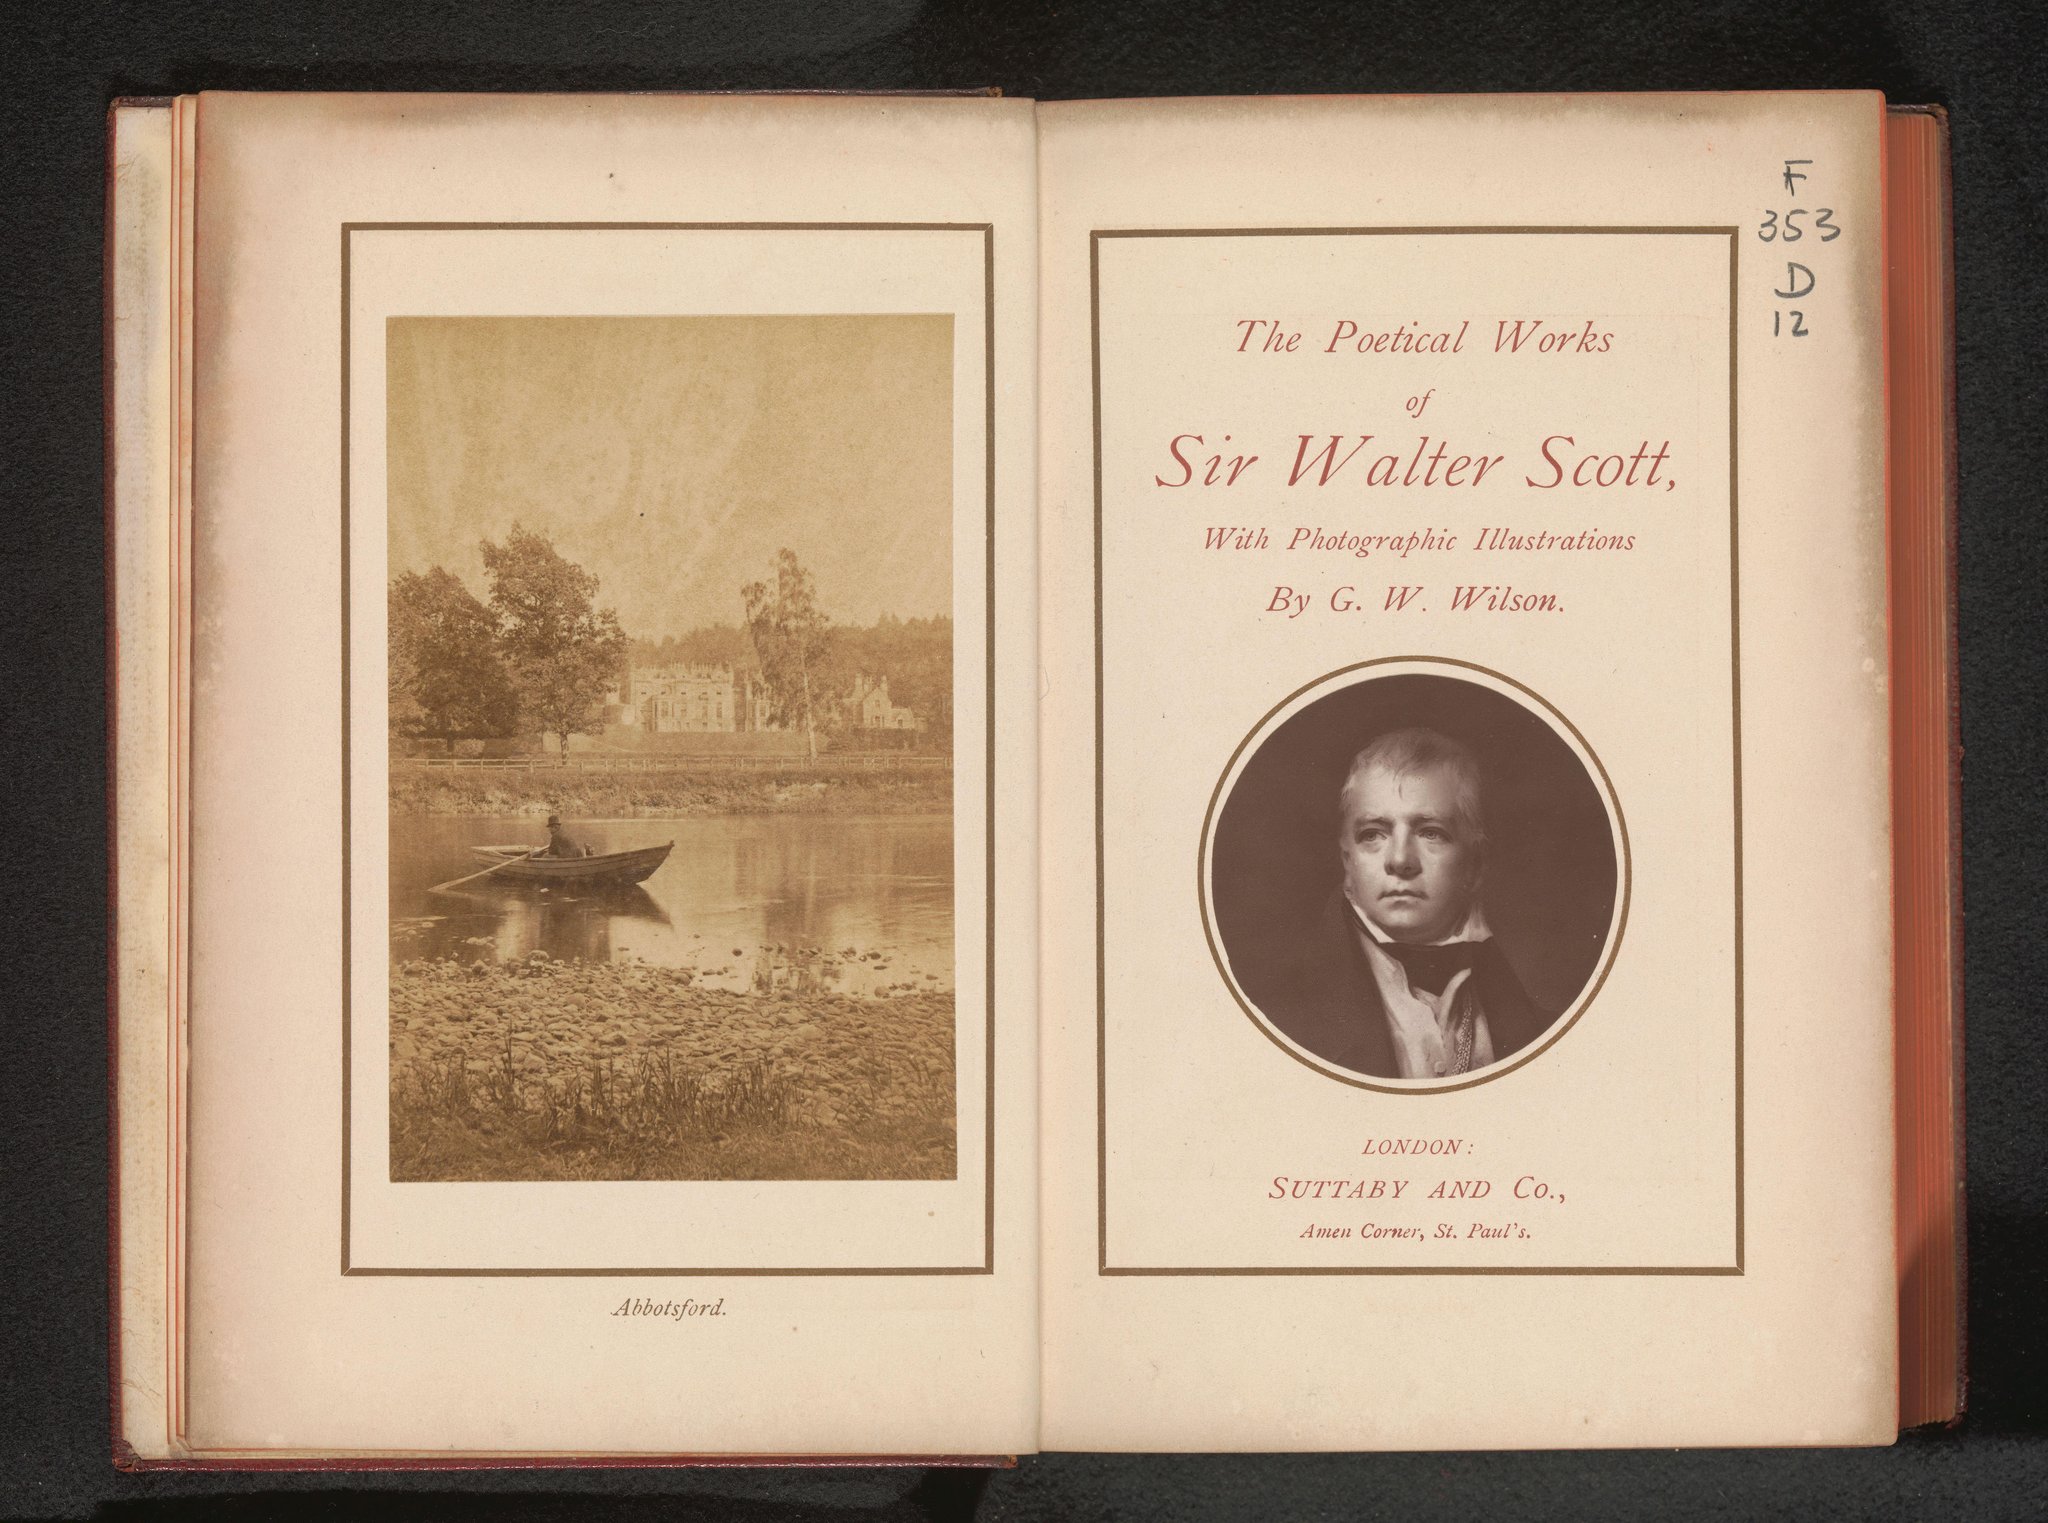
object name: book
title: The poetical works of Sir Walter Scott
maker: walter scott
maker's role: dichter, schrijver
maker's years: 1771-1832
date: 1890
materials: linen, paper, photographic support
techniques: albumen print, etching, printing, woodburytype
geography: london